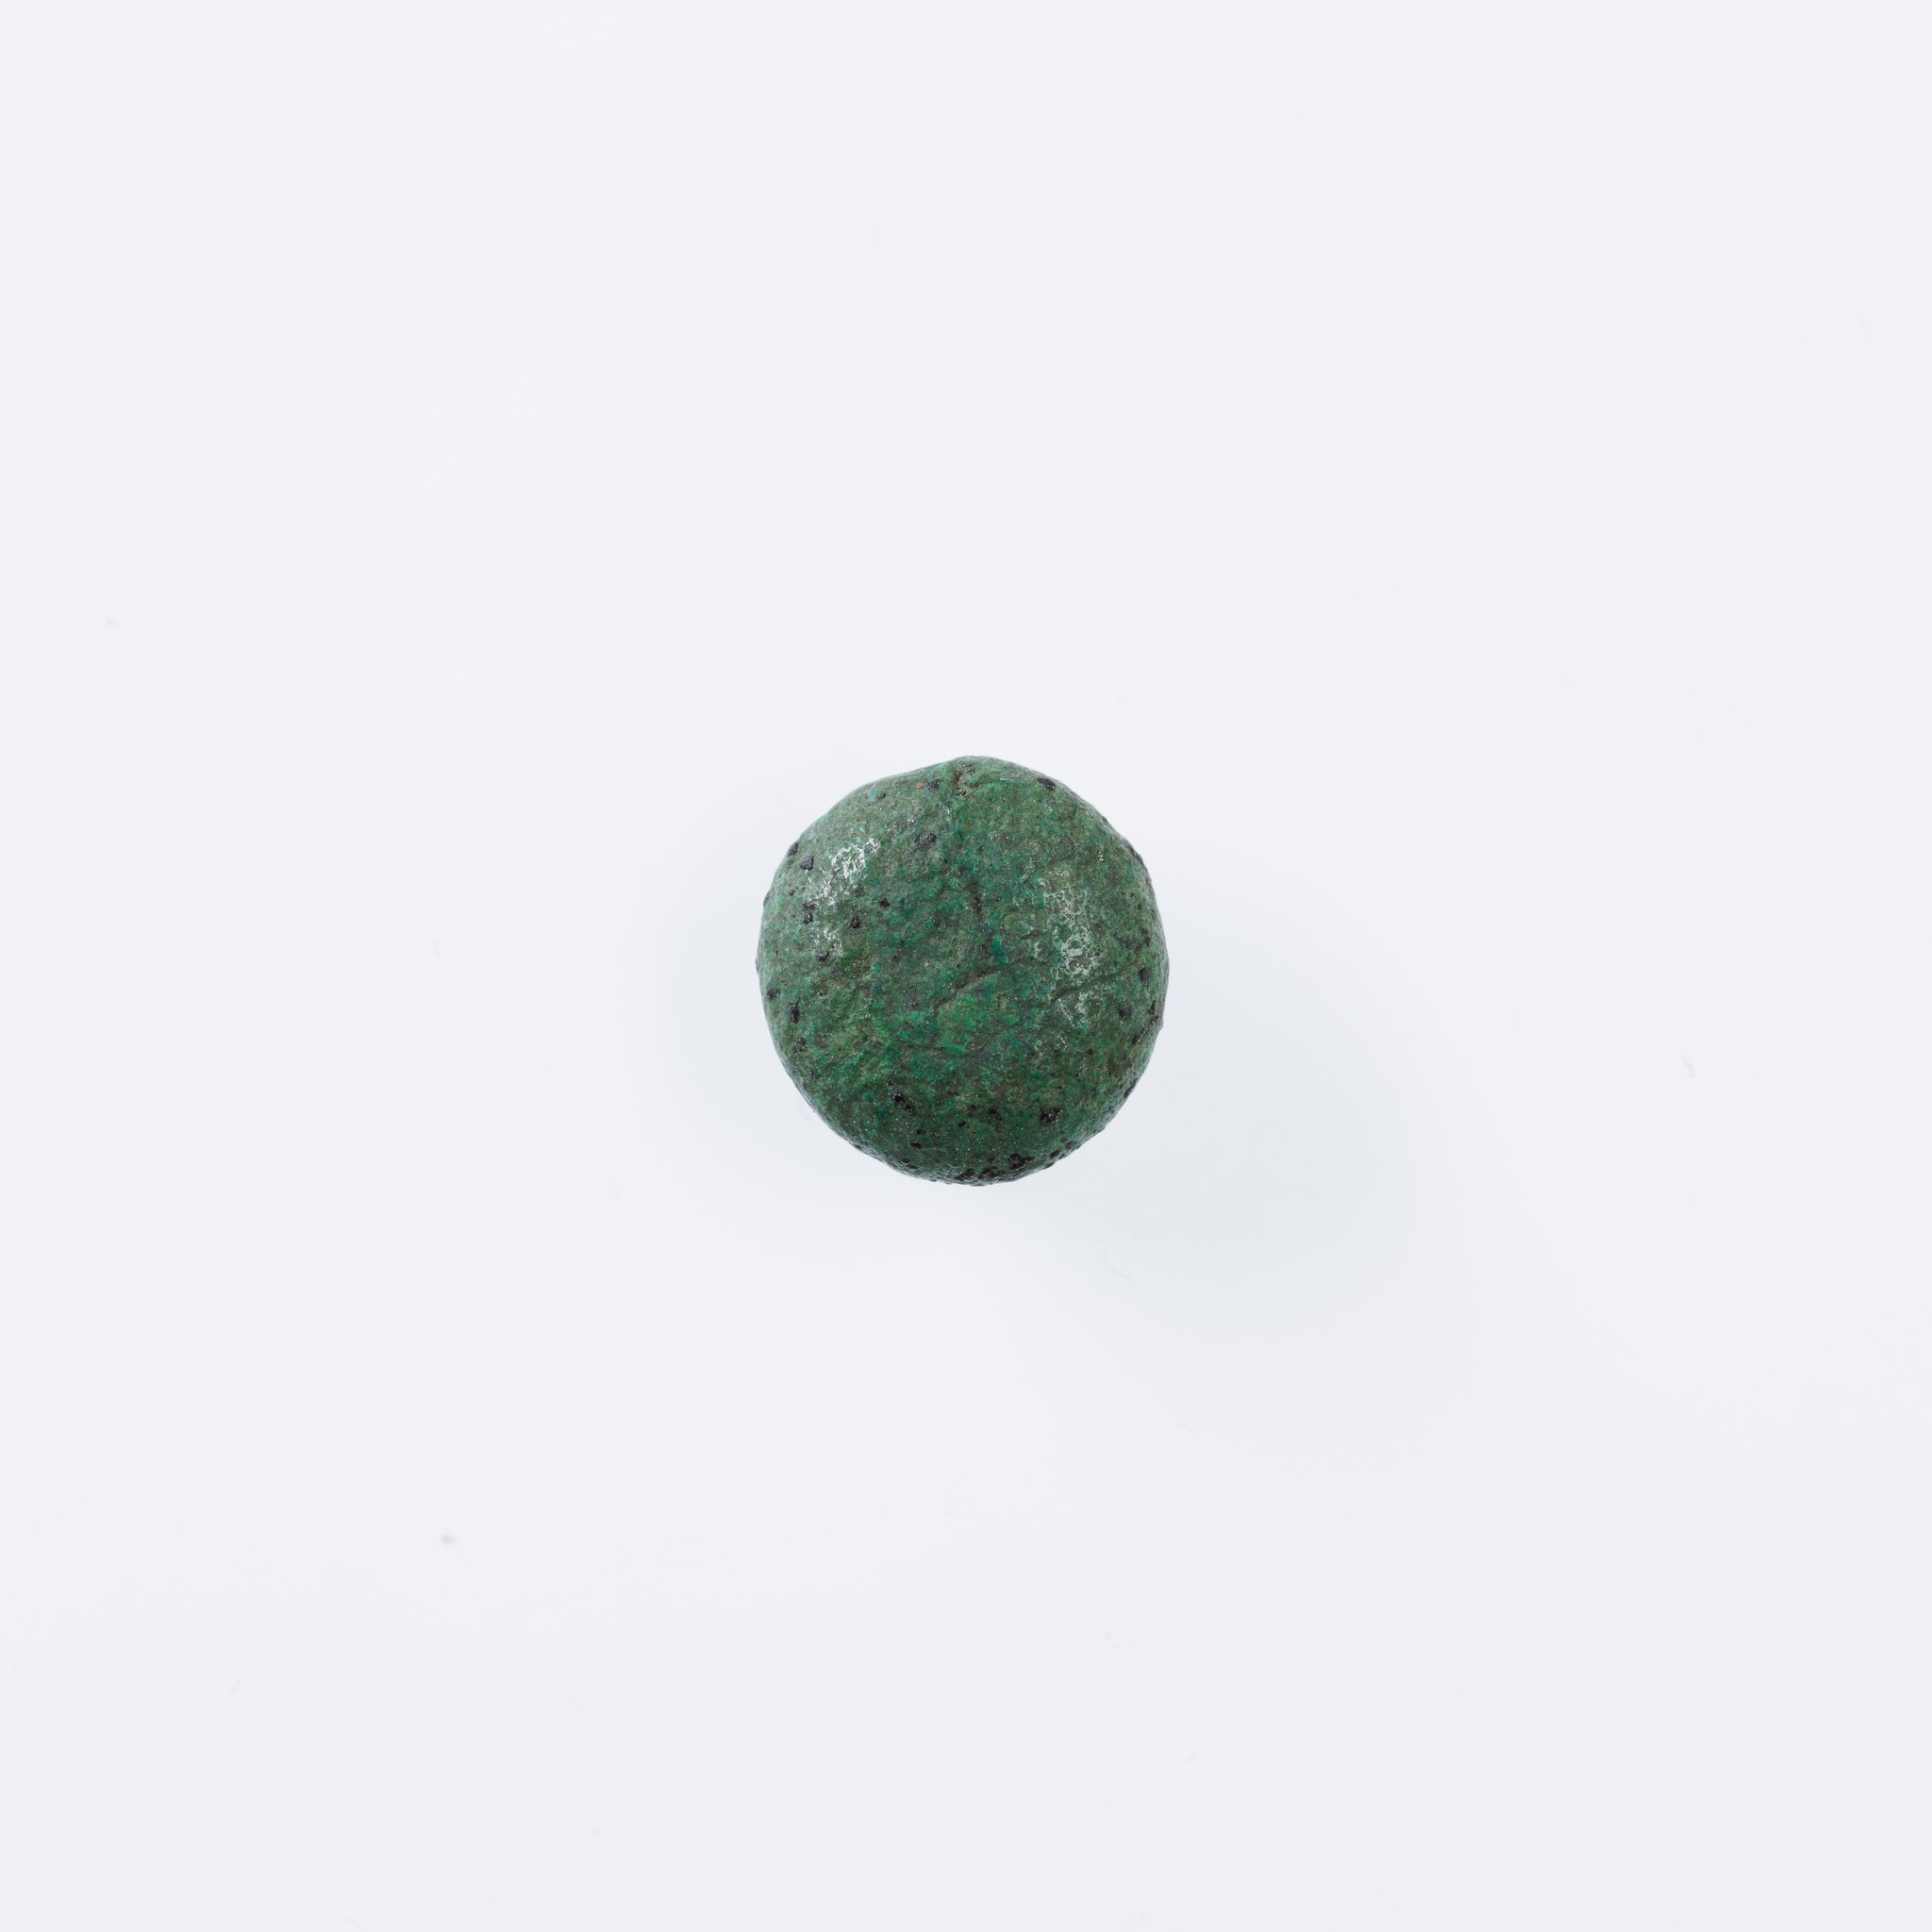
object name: weight, 1 4 kedet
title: Weight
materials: copper alloy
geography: egypt